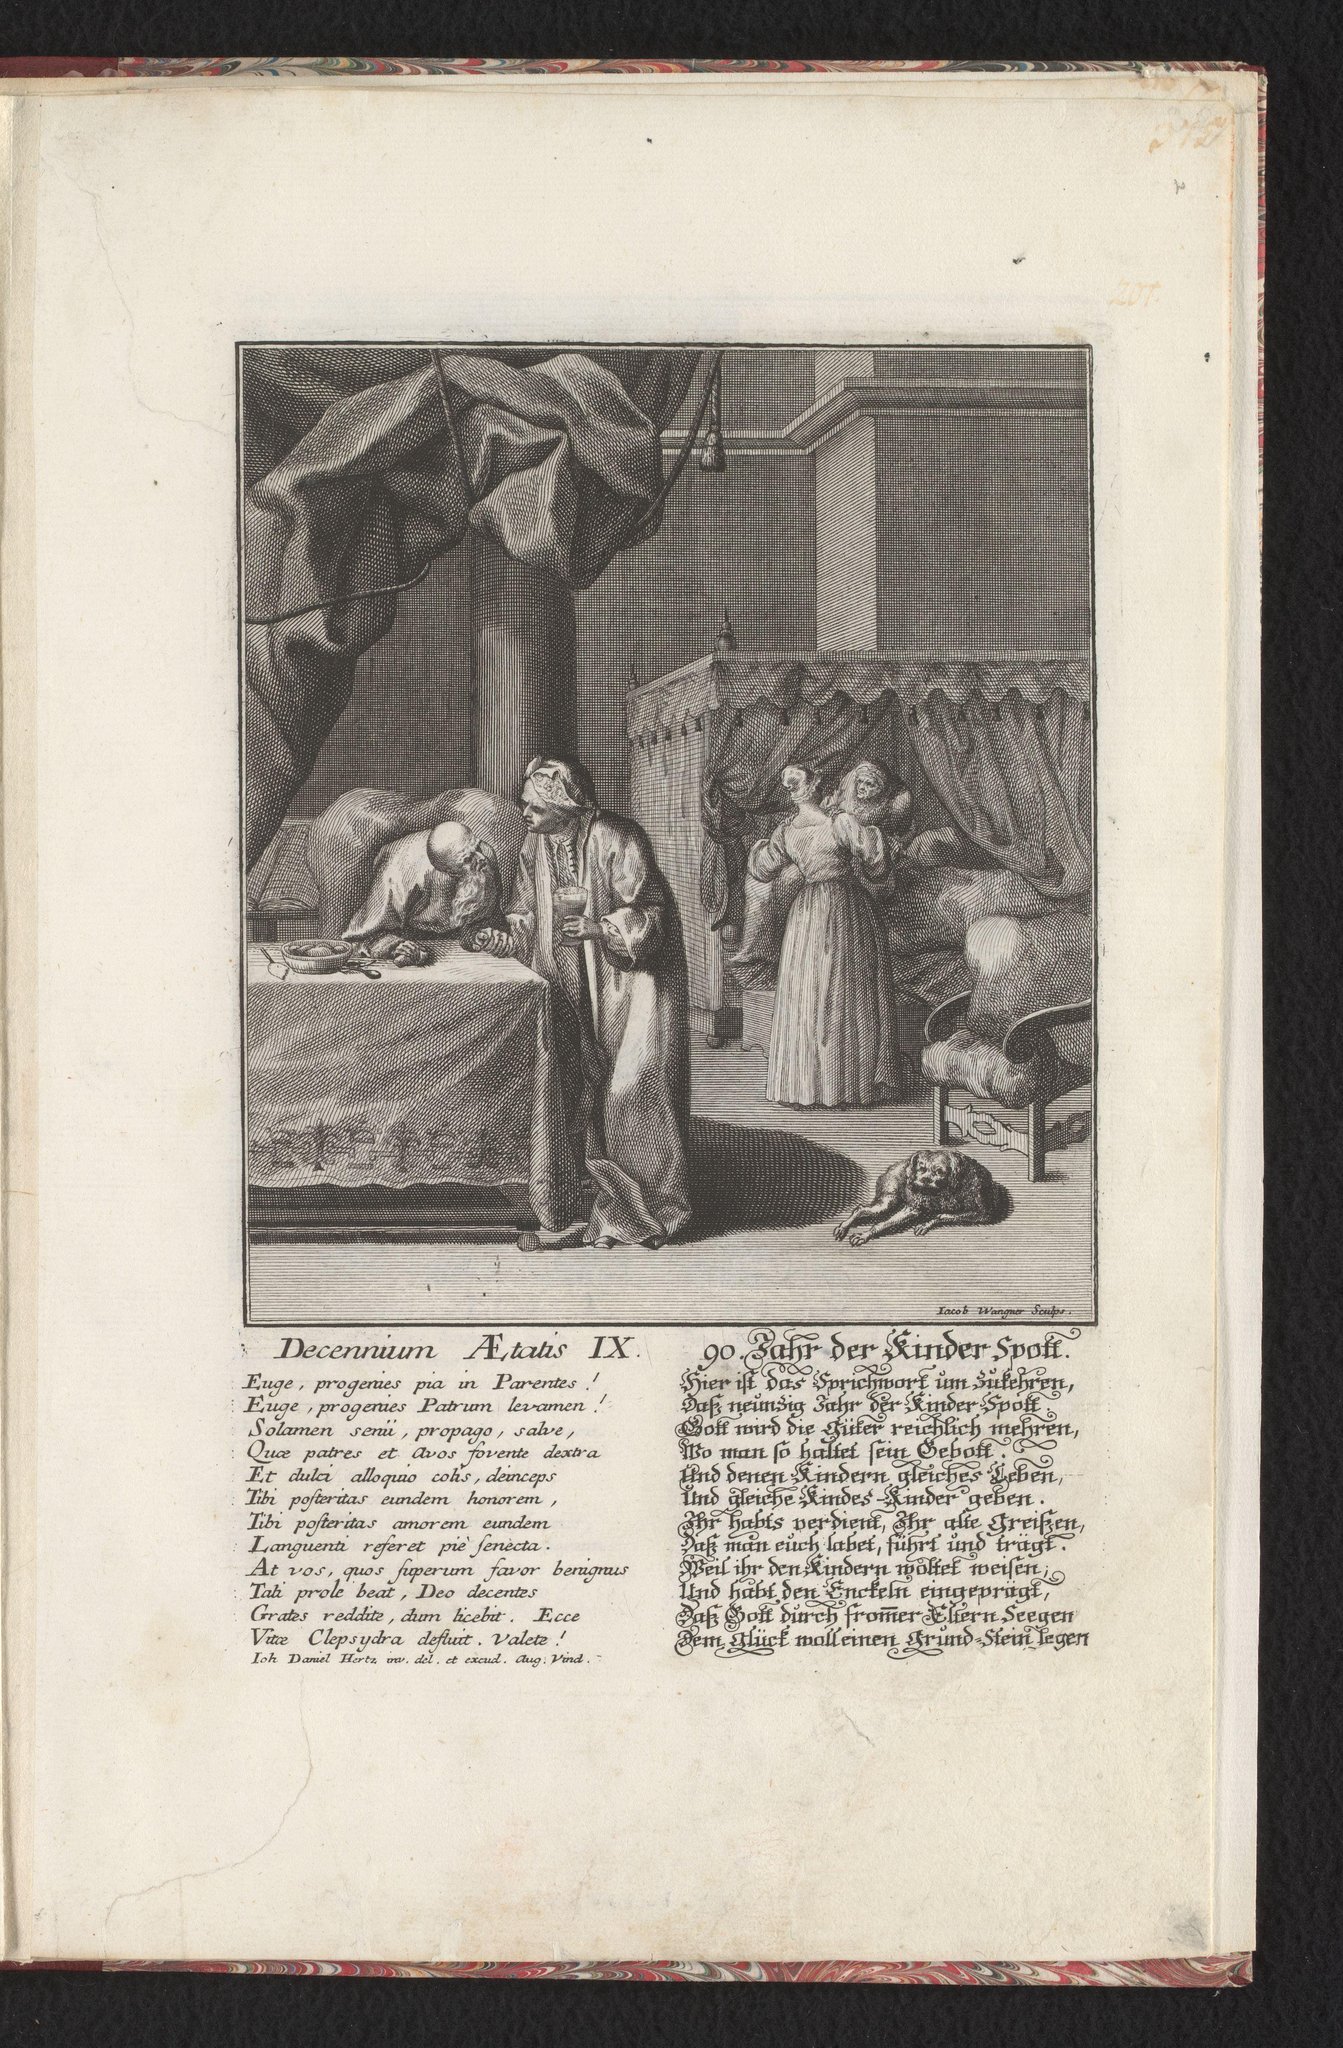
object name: album leaf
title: Tien leeftijden van de mens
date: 1725-1730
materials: paper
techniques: engraving, etching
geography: augsburg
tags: 80-90 years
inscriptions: watermark, number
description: Een oude man met baard zit aan tafel met eetgerei. Hij wordt geholpen door een vrouw. Rechtsachter een oude vrouw in een hemelbed. Met gedichten in Latijn en Duits. Deze prent maakt deel uit van een album.